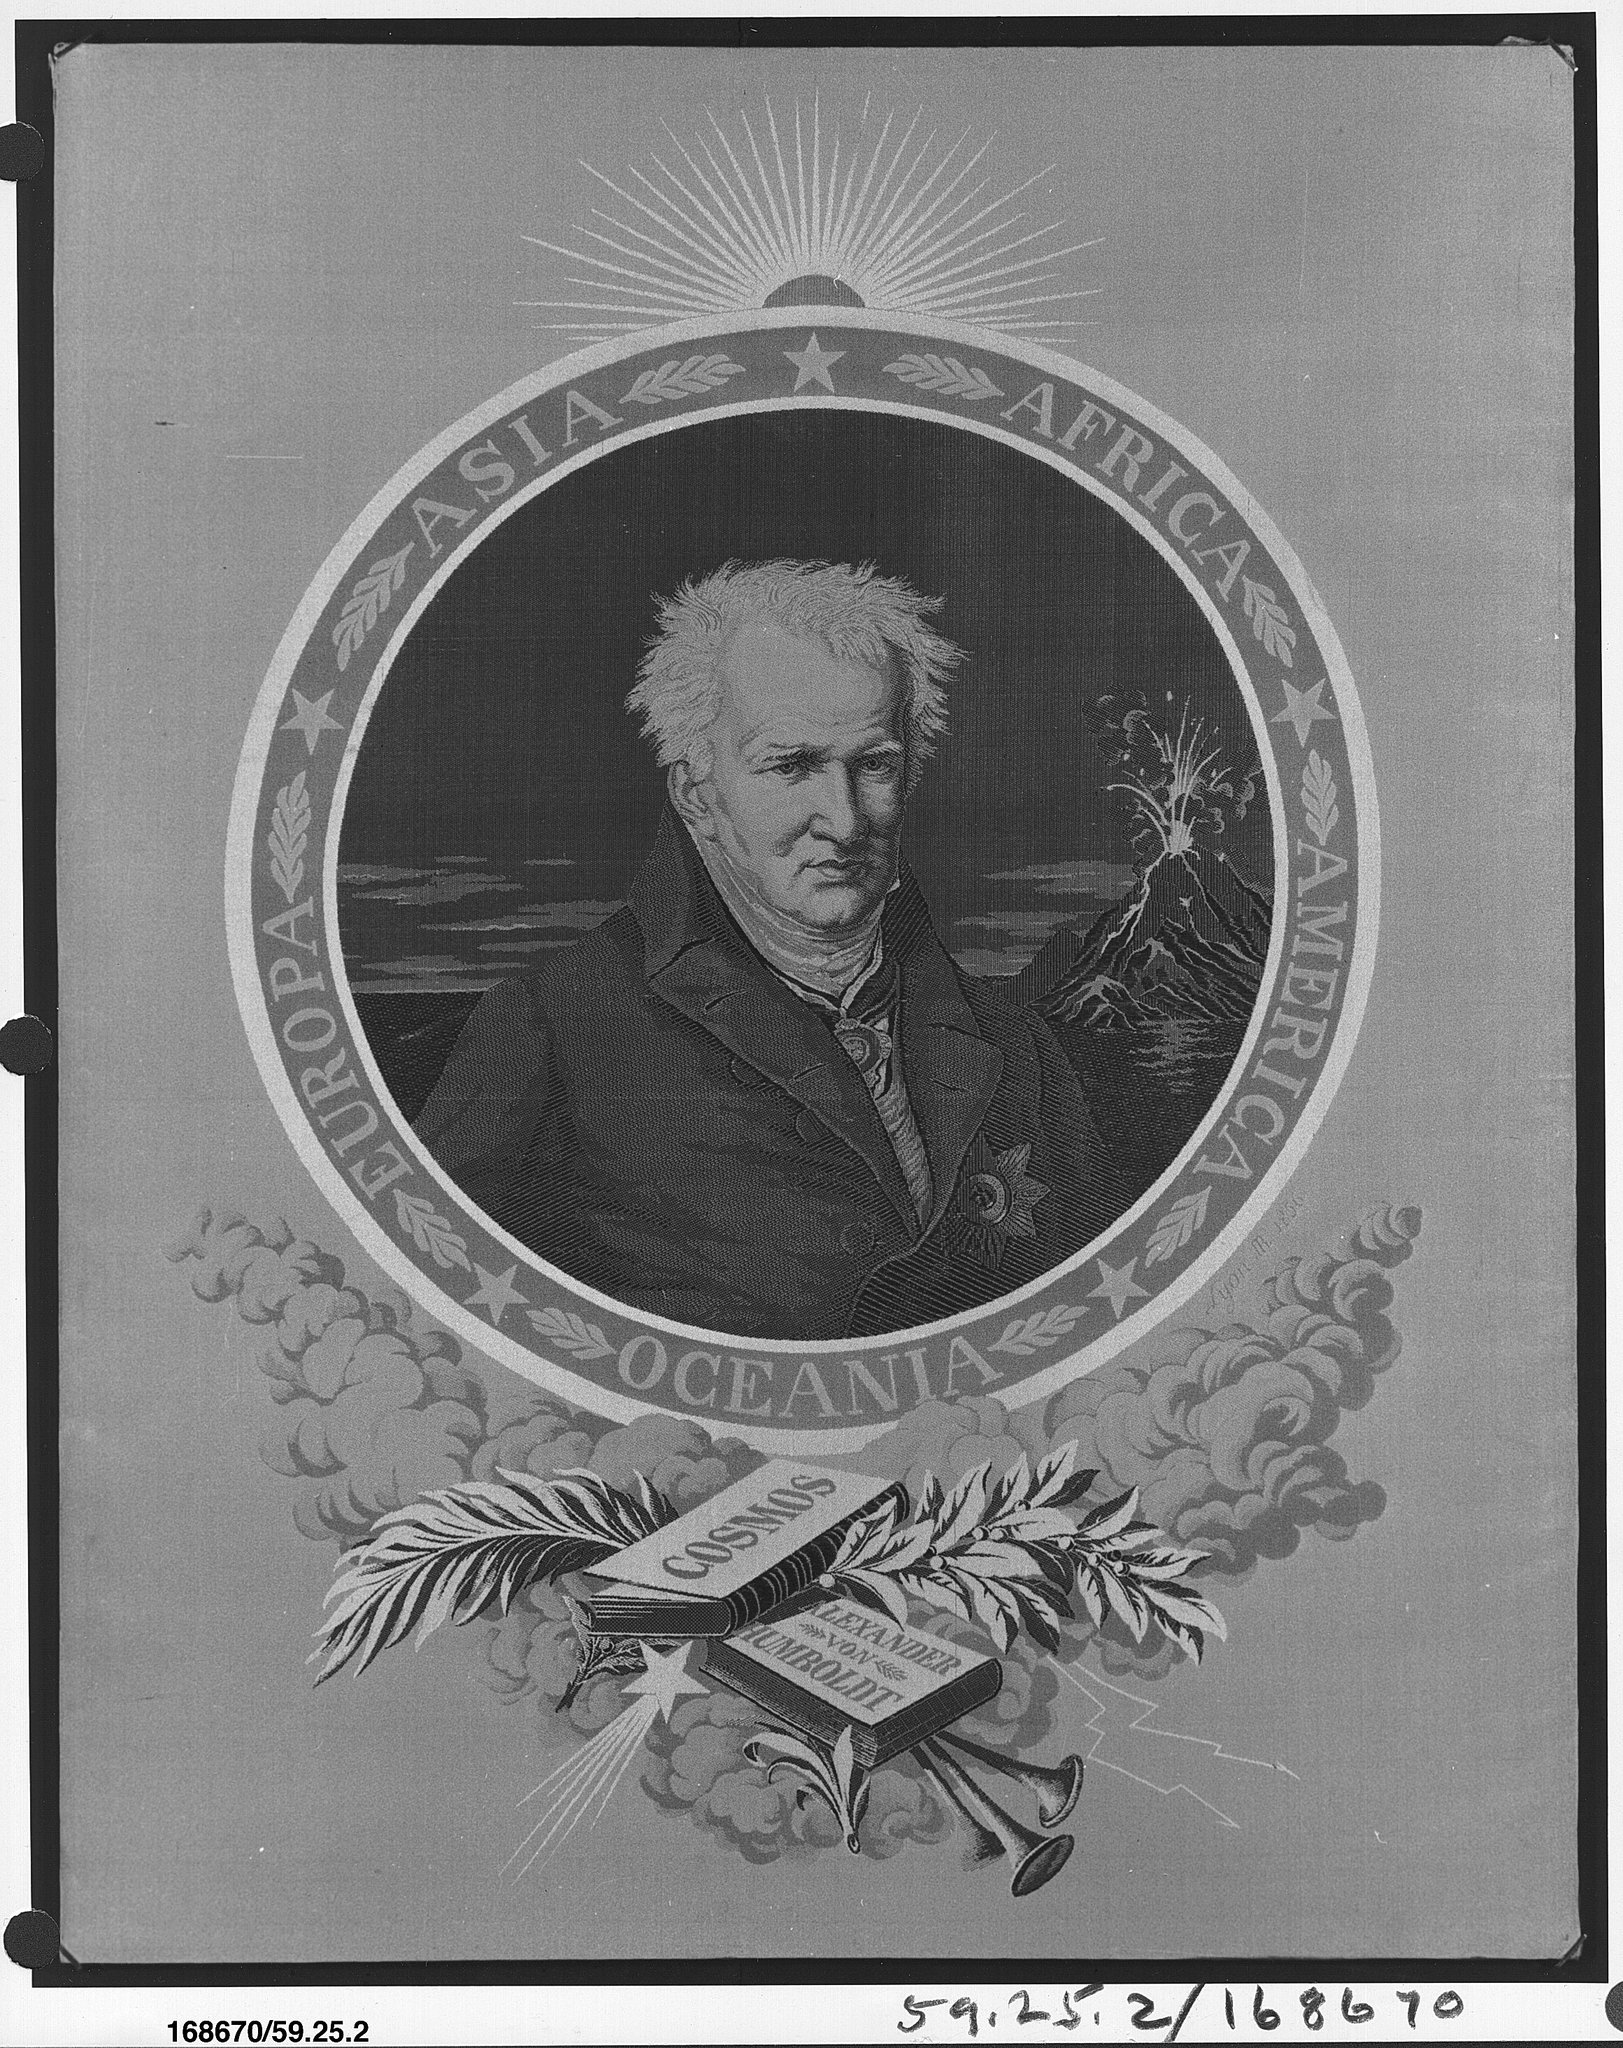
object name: portrait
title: Alexander von Humboldt (1769–1859)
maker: nicolas romain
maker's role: designer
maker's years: 1808-1858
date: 1856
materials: silk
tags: men,portraits